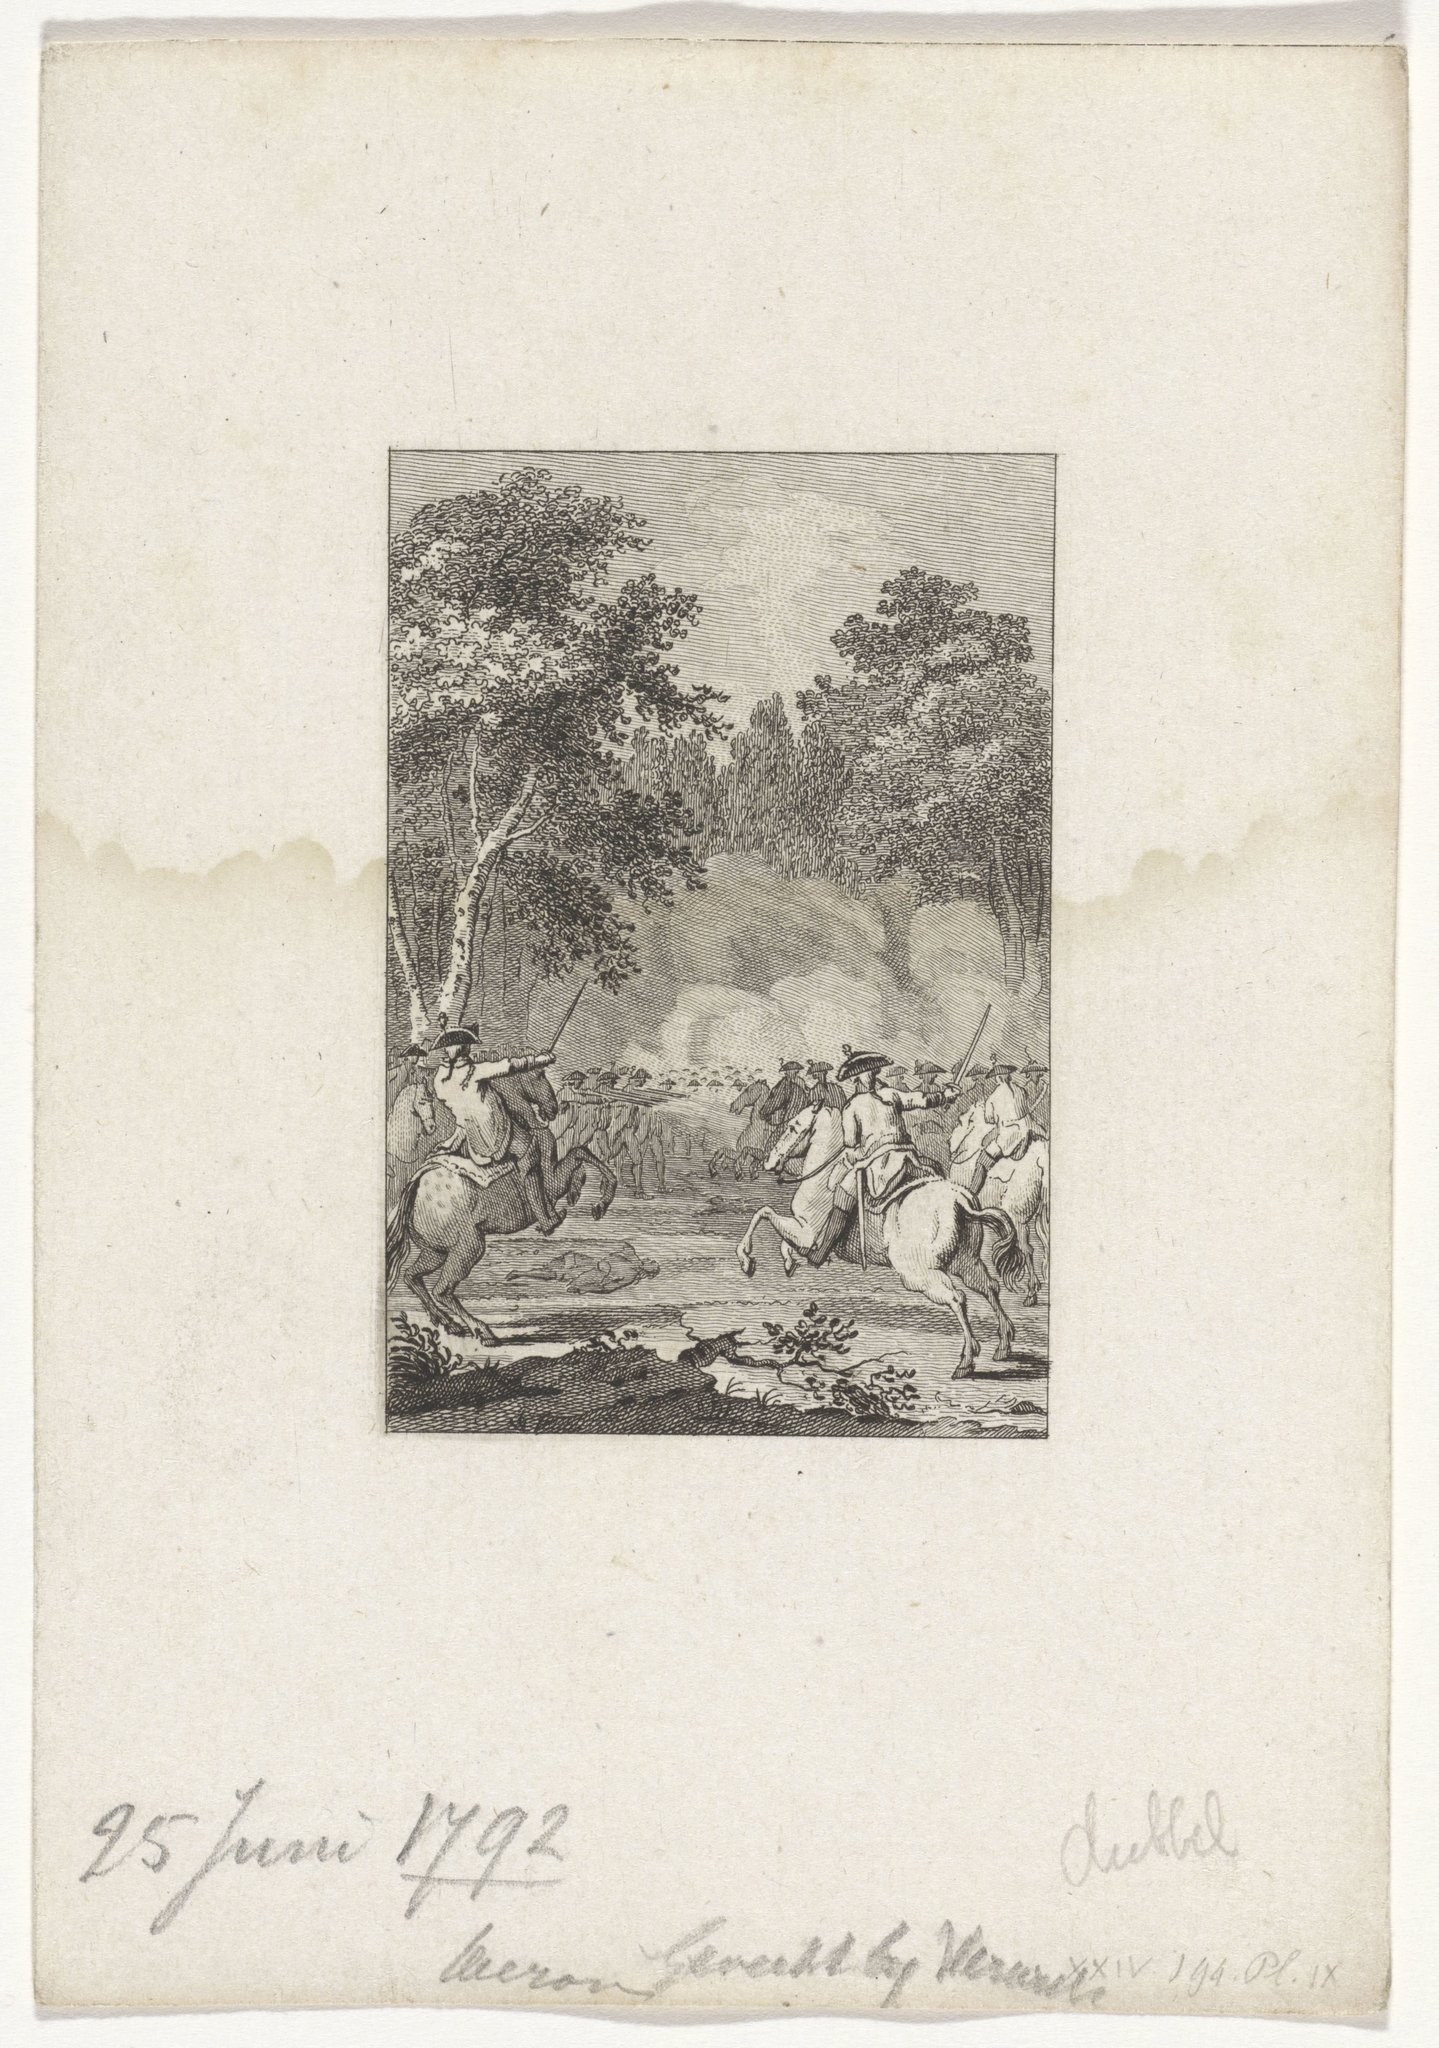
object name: history print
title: Gevecht bij Warwick, 1792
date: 1783-1795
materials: paper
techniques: etching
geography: amsterdam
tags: battle (+ cavalry, horsemen)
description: Illustratie voor: J. Fokke. Geschiedenissen der Vereenigde Nederlanden voor de vaderlandsche jeugd. Amsterdam: Johannes Allart, 1783-1795, 25 delen. deel XXIV pl. IX.